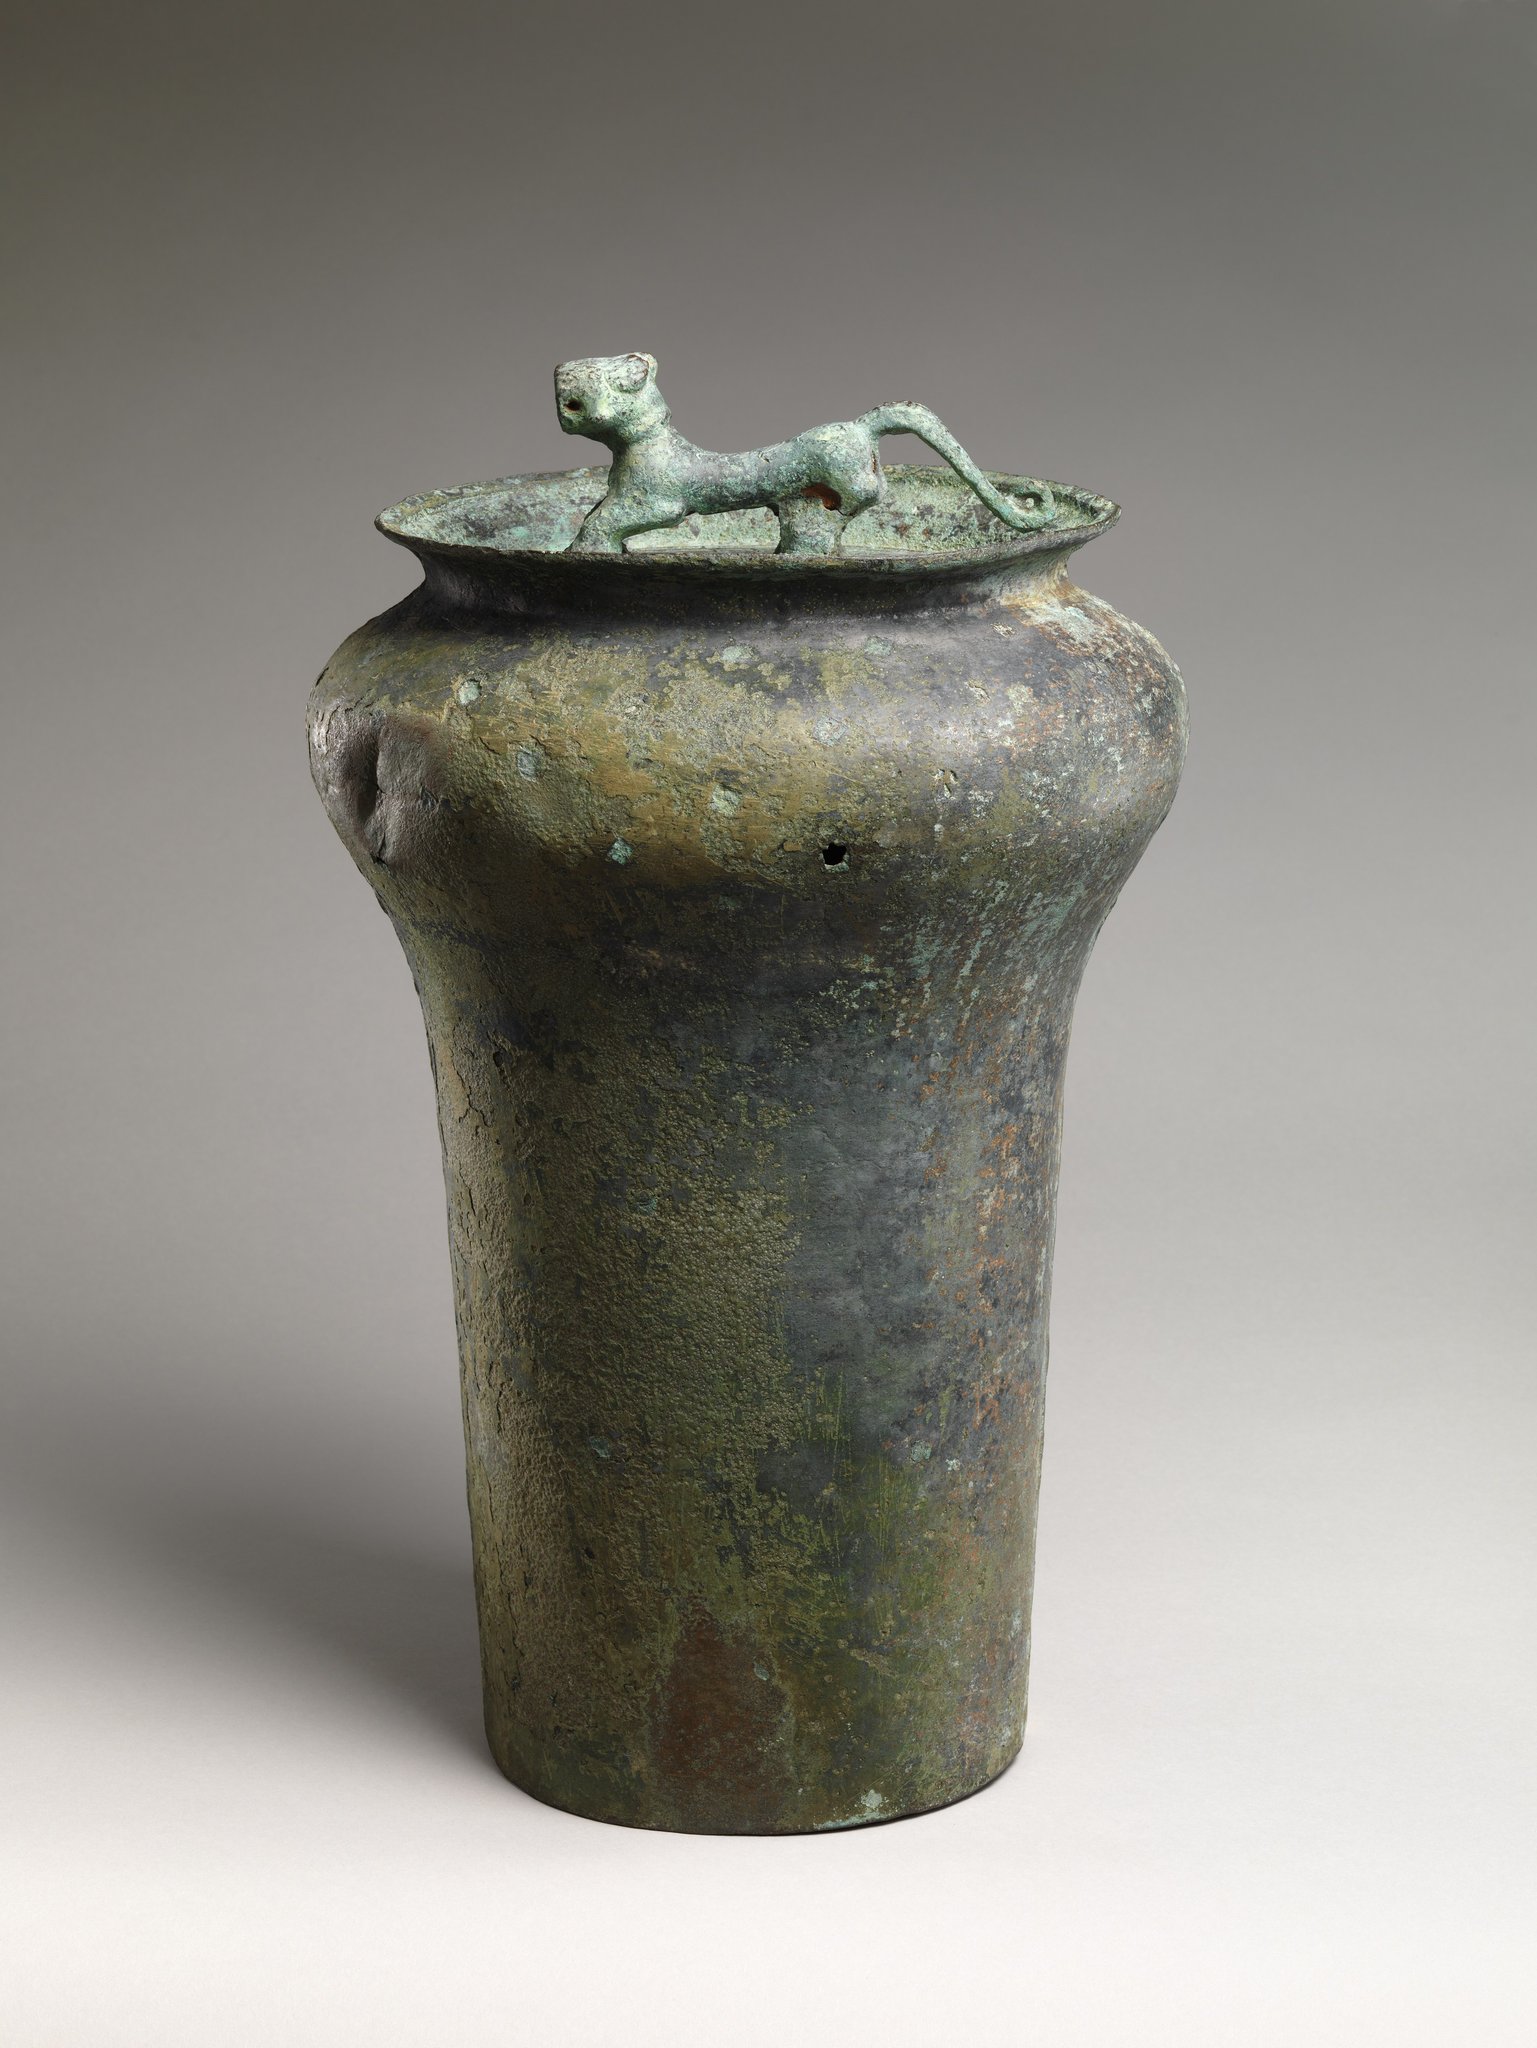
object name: bell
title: Bell (Chunyu)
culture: chinese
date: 300-101 BCE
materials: bronze